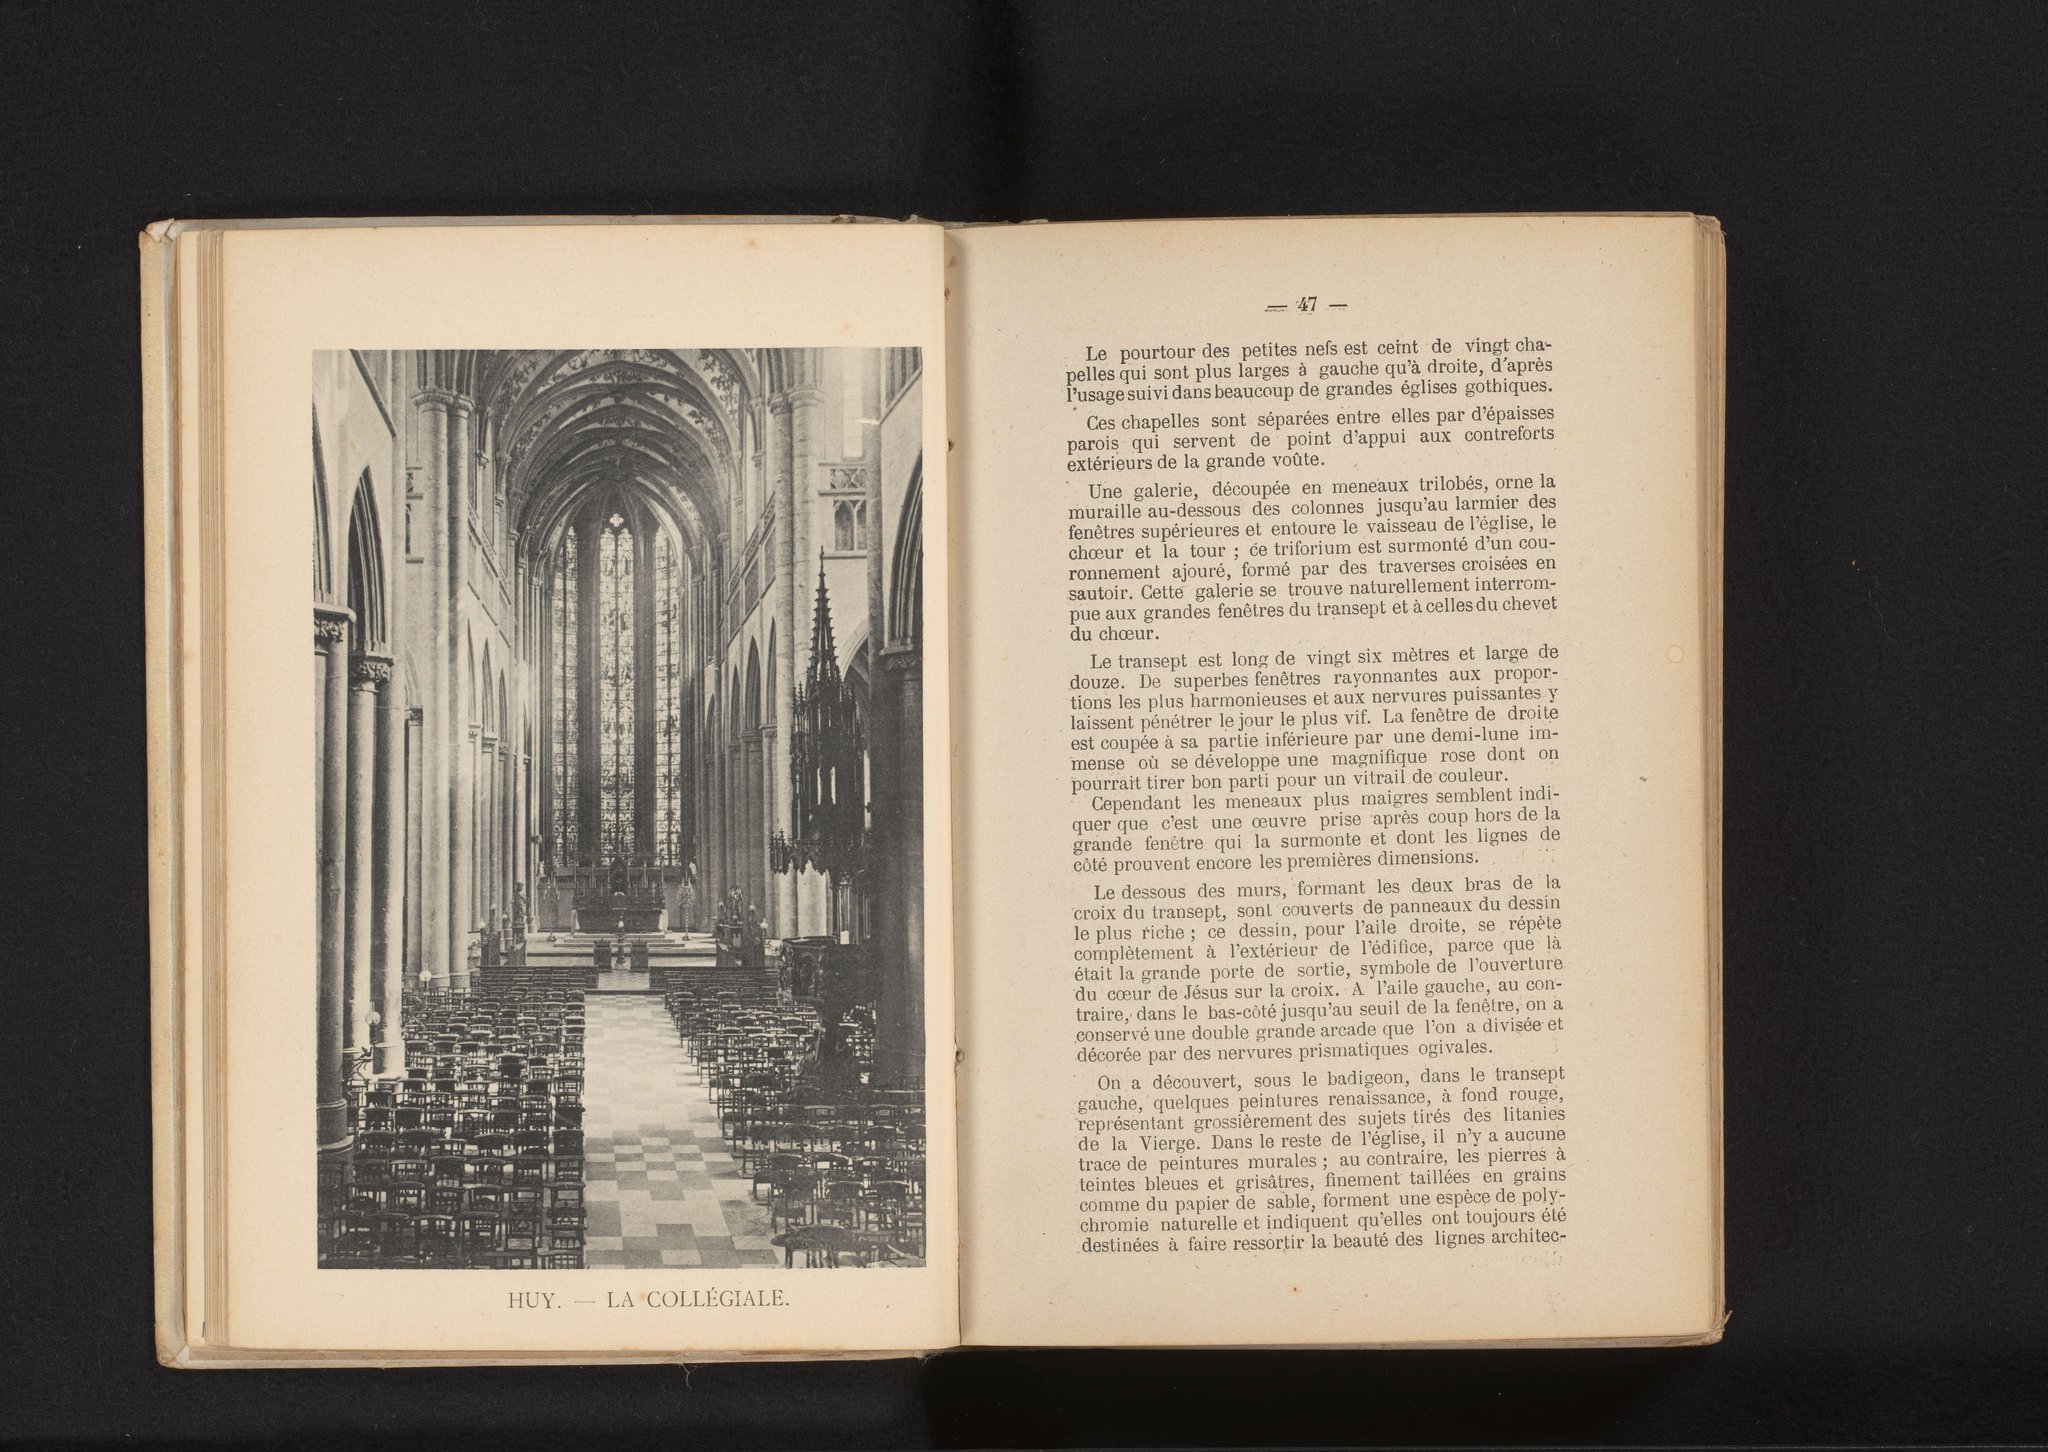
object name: photomechanical print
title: Huy. - La Collégiale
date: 1885-1890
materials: paper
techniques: photograph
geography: brussels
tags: interior of church